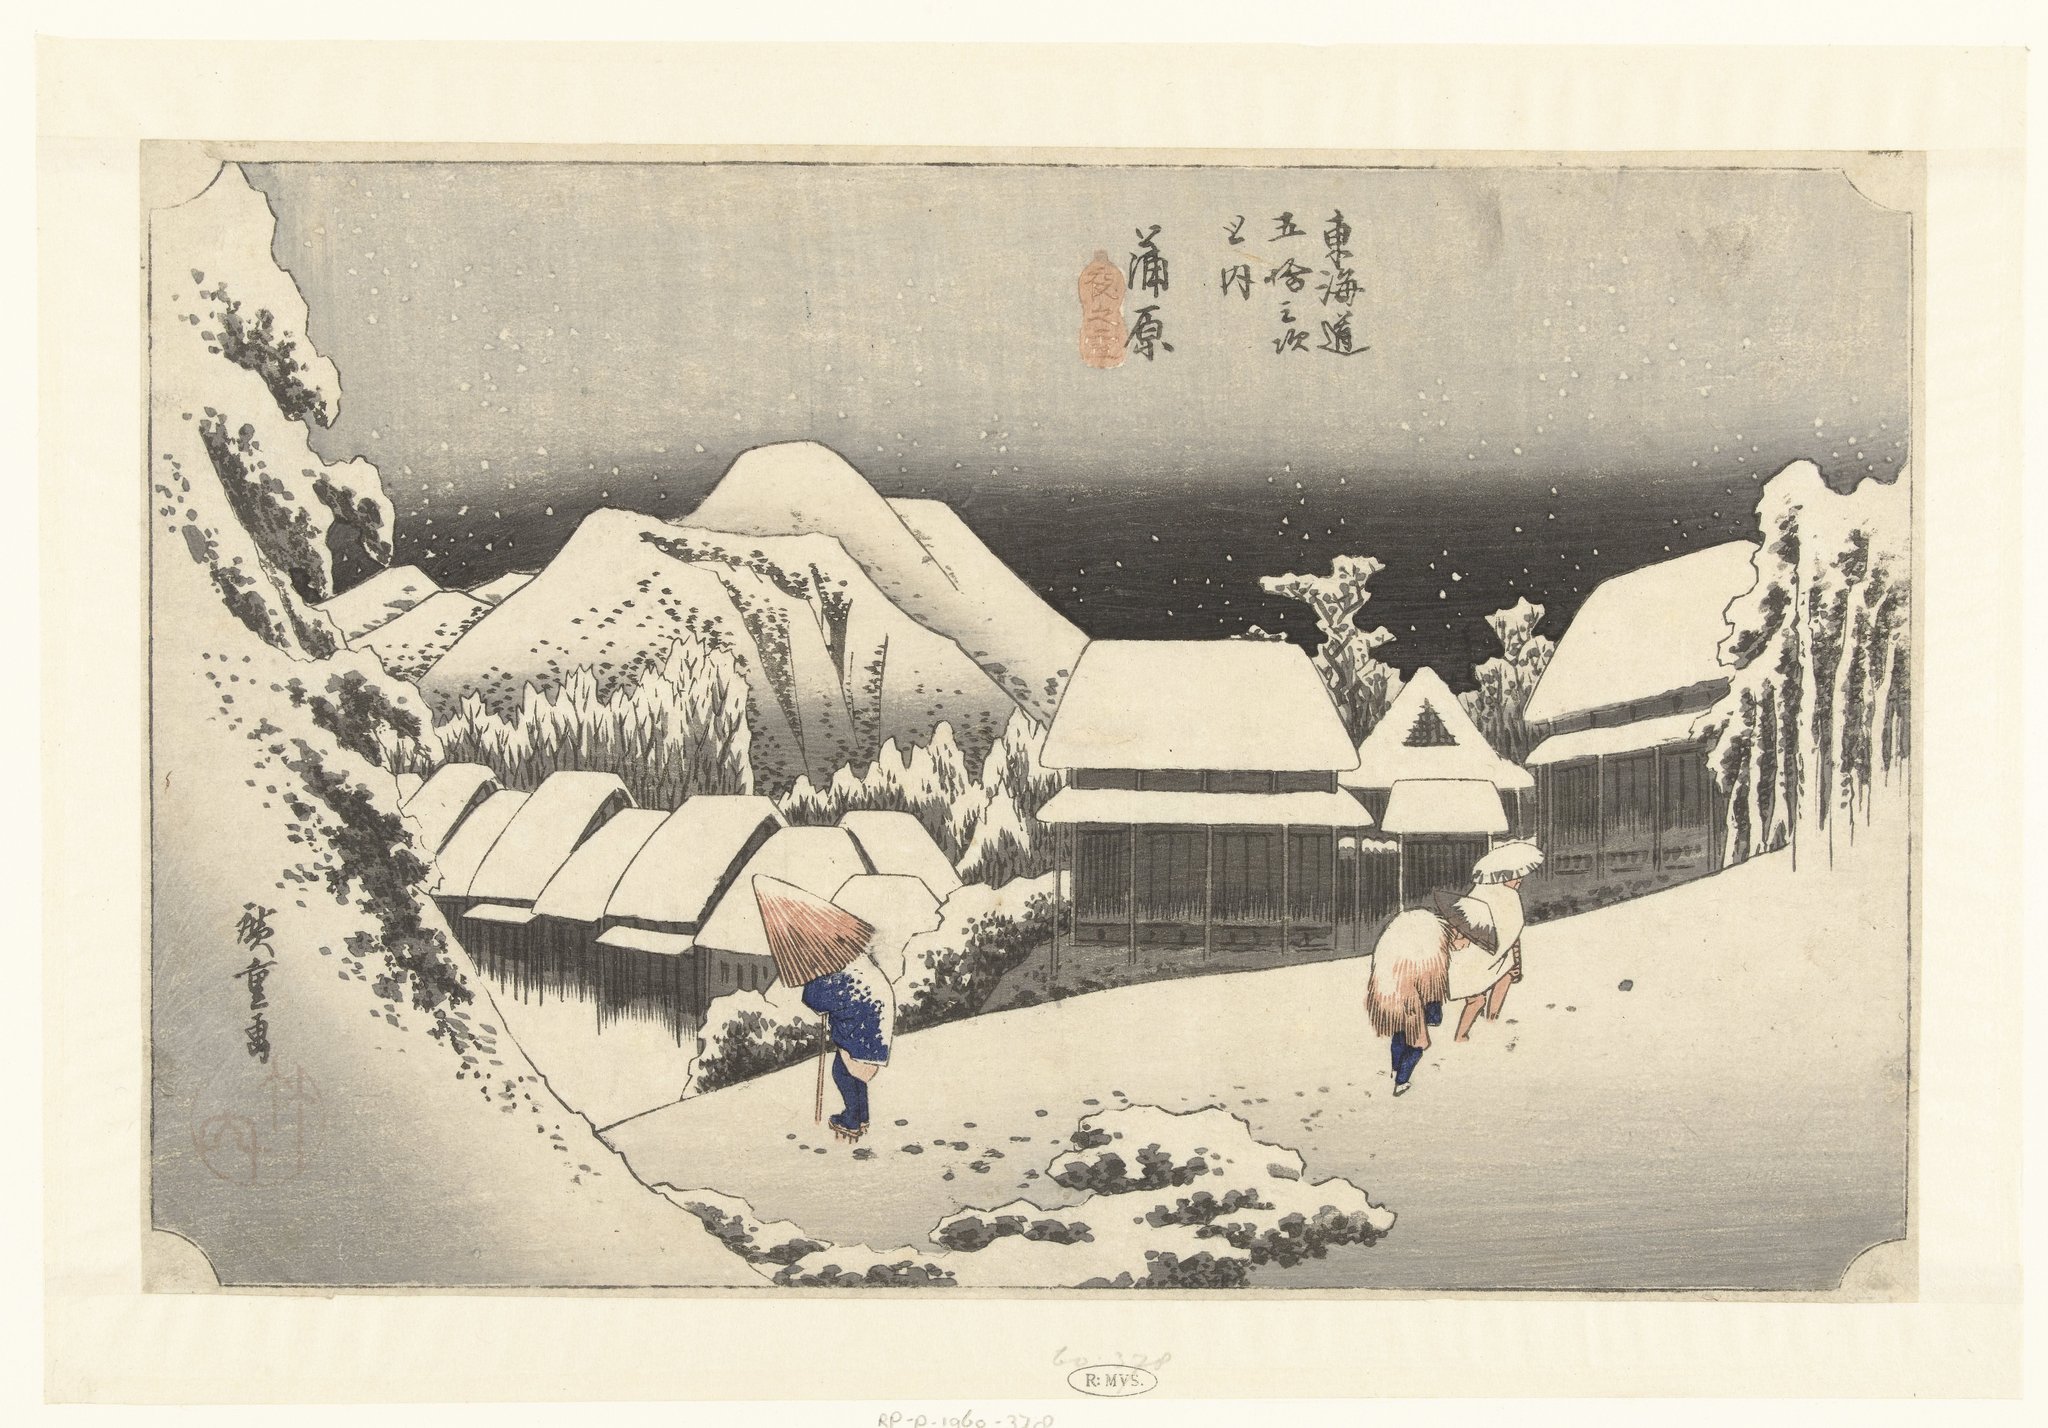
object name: print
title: De 53 stations van de Tokaido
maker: utagawa hiroshige (i)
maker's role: draughtsman, print maker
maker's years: 1797-1858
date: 1828-1835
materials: paper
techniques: woodcut, nishiki e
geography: japan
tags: city-view, and landscape with man-made constructions, snow, 'en route', traveller under way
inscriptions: collector's mark: Lugt 2228, signature: ‘Hiroshige ga’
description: Drie reizigers in het dorp Kanbara onder een dik pak sneeuw, bij avond.